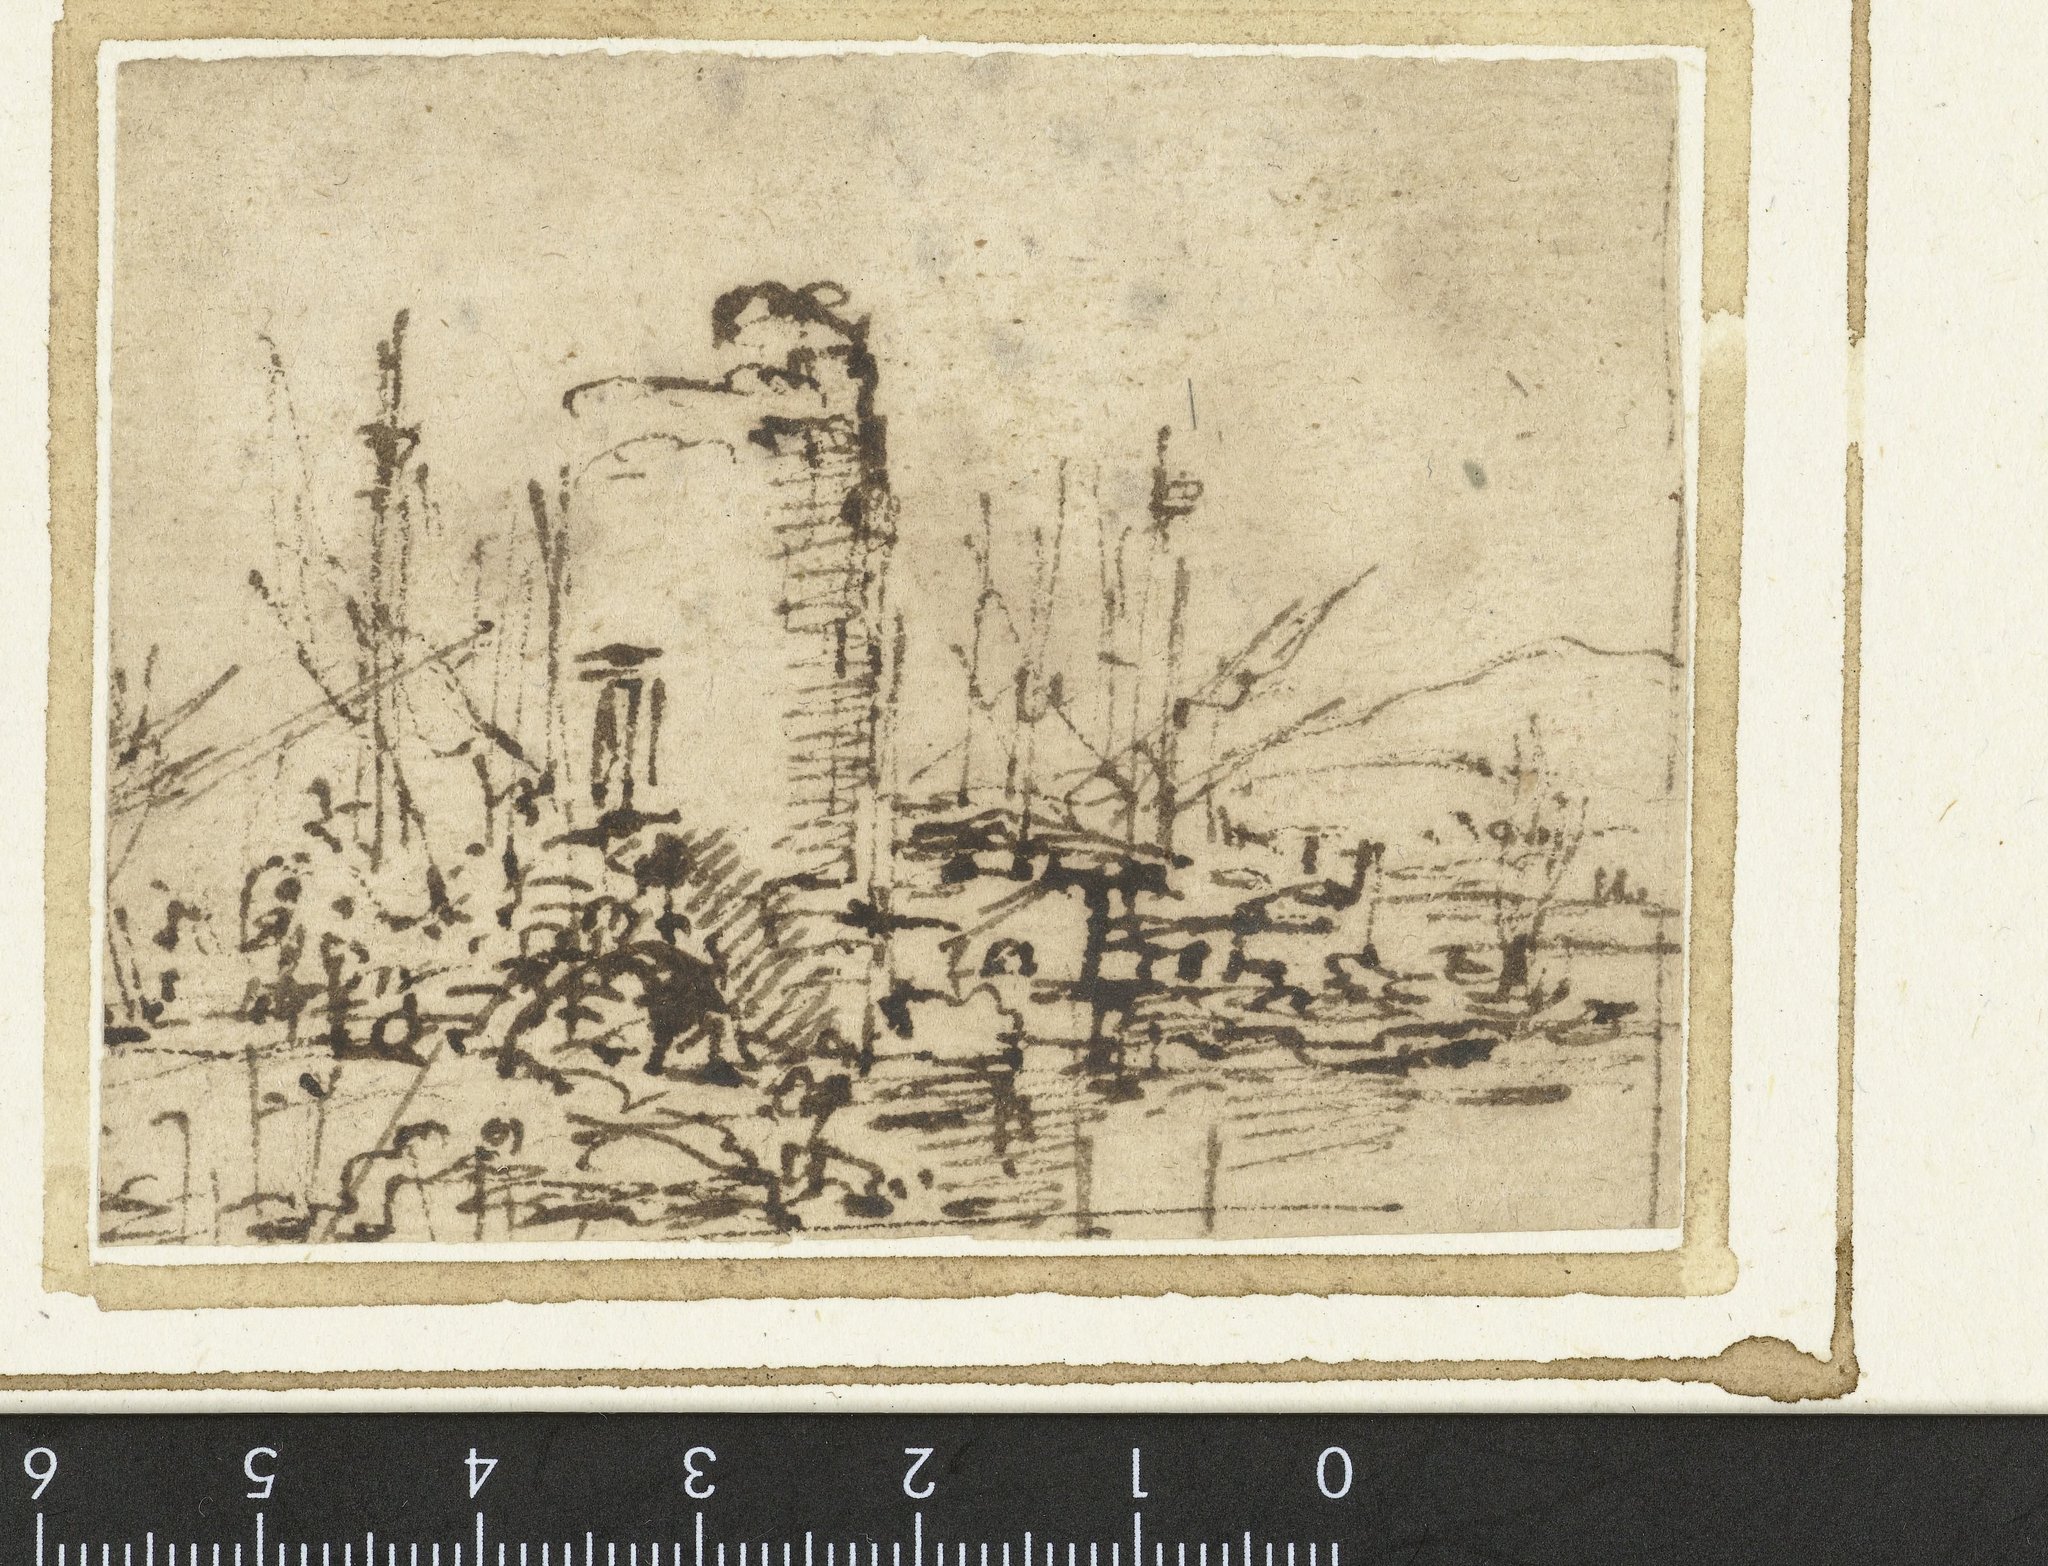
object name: drawing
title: Ronde toren aan een haven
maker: salvator rosa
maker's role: draughtsman, painter, print maker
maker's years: 1615-1673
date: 1640-1659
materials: ink, paper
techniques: pen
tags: harbour